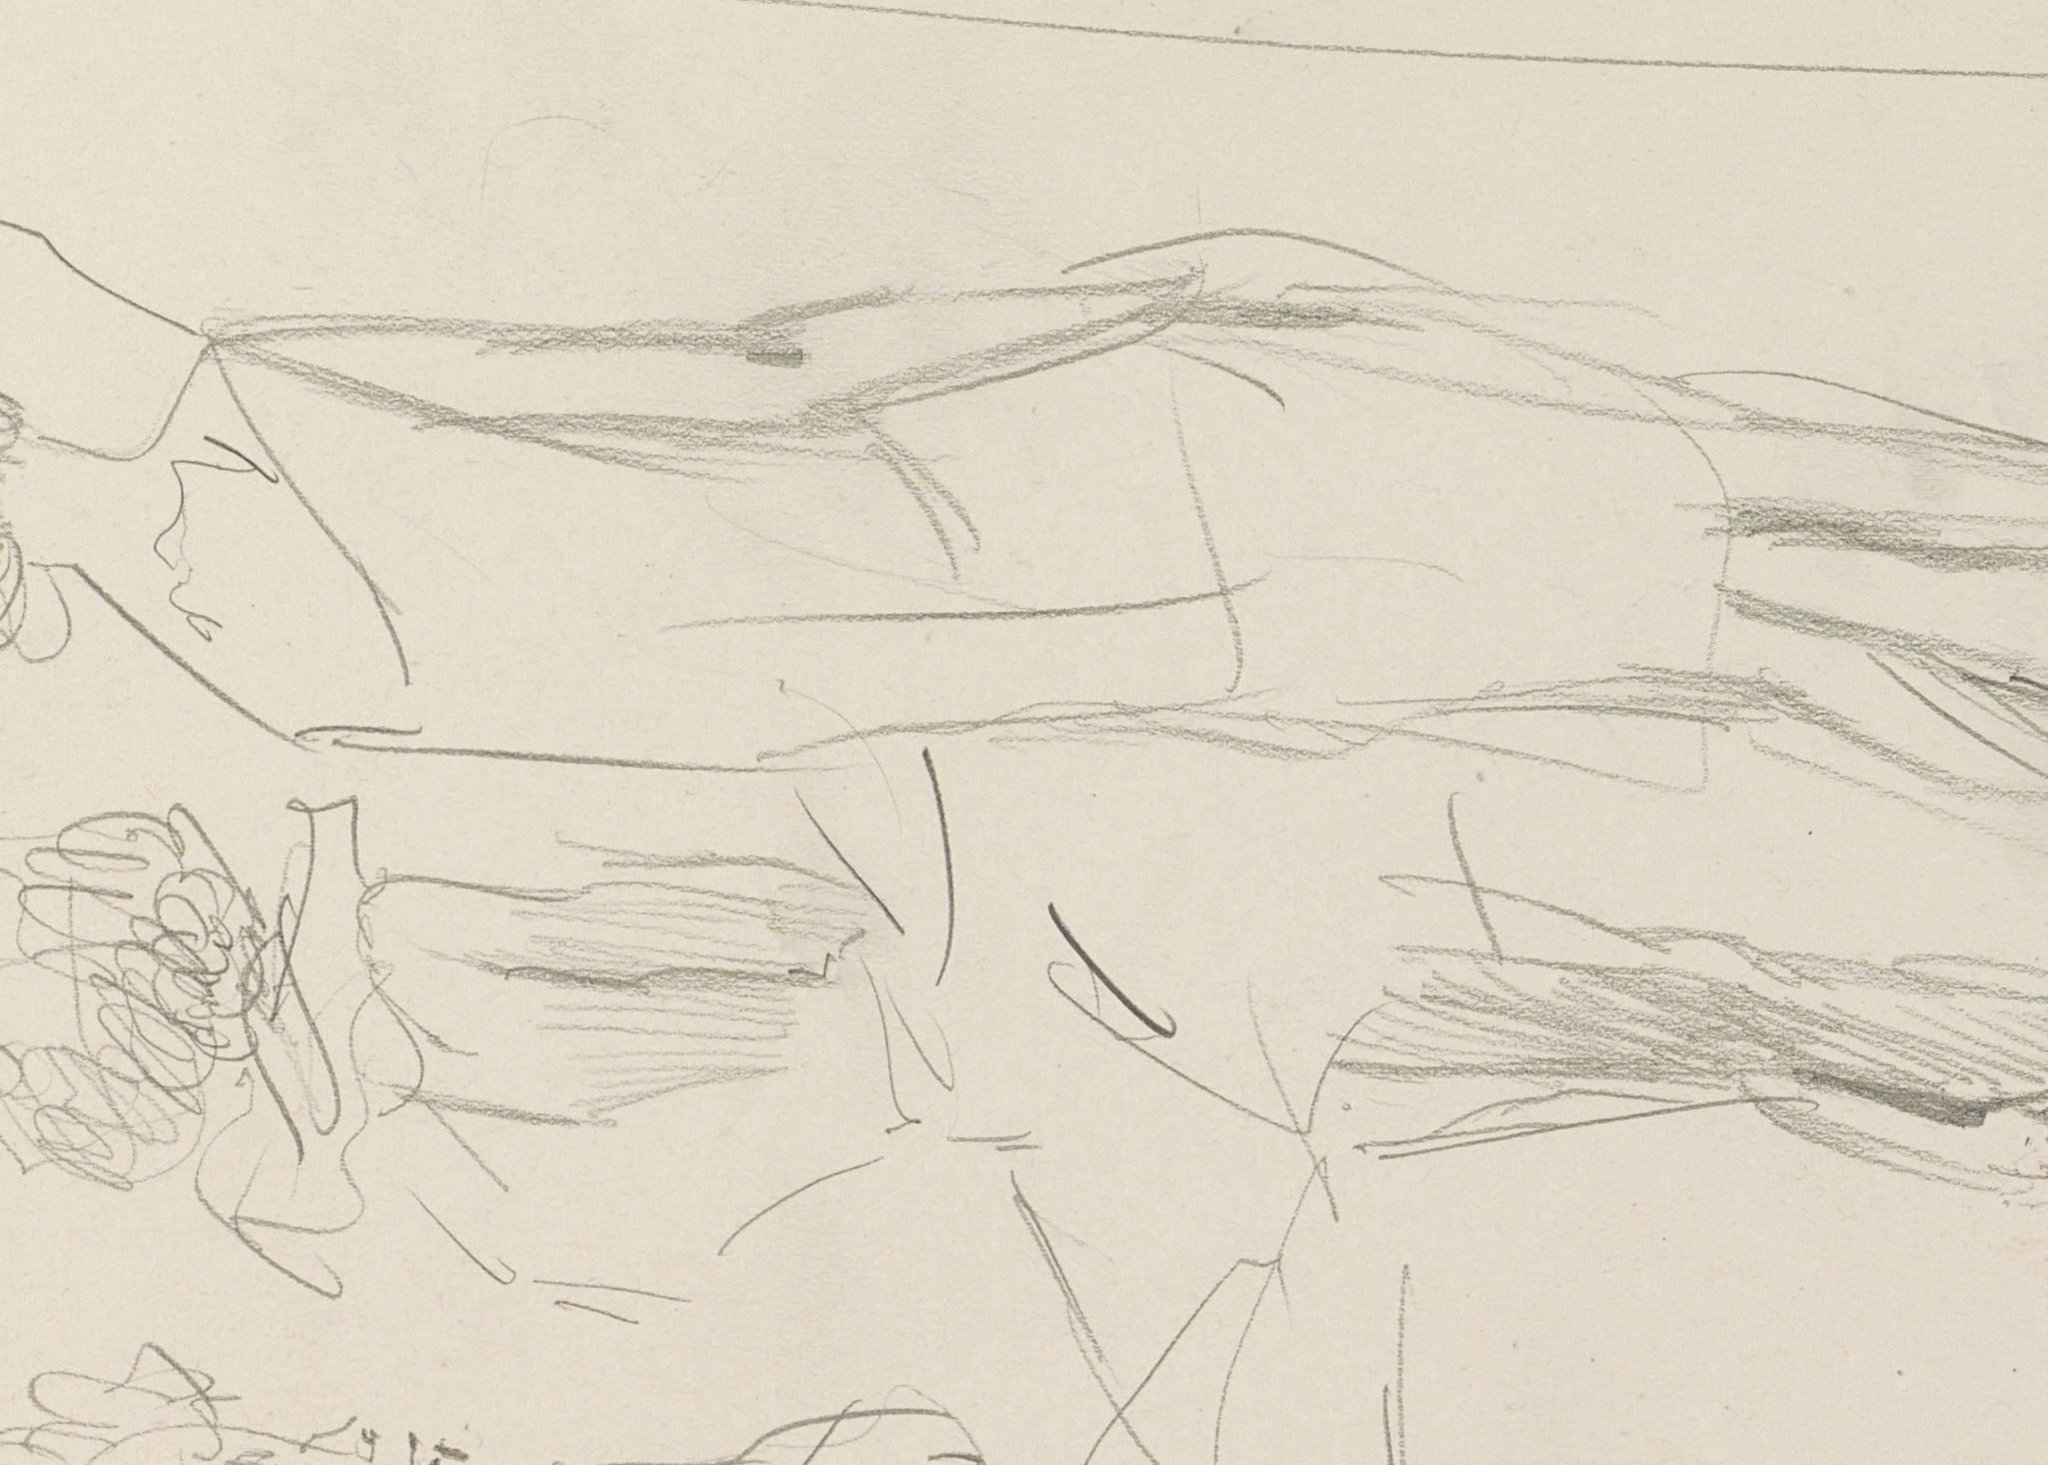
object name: sketchbook leaf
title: Studieblad met vier vrouwen en een man in uniform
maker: isaac israels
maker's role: draughtsman, painter, print maker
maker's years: 1865-1934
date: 1915-1934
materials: paper, pencil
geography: the hague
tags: adult man, standing figure - aa - female human figure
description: Blad 25 verso uit schetsboek VI met 33 bladen.